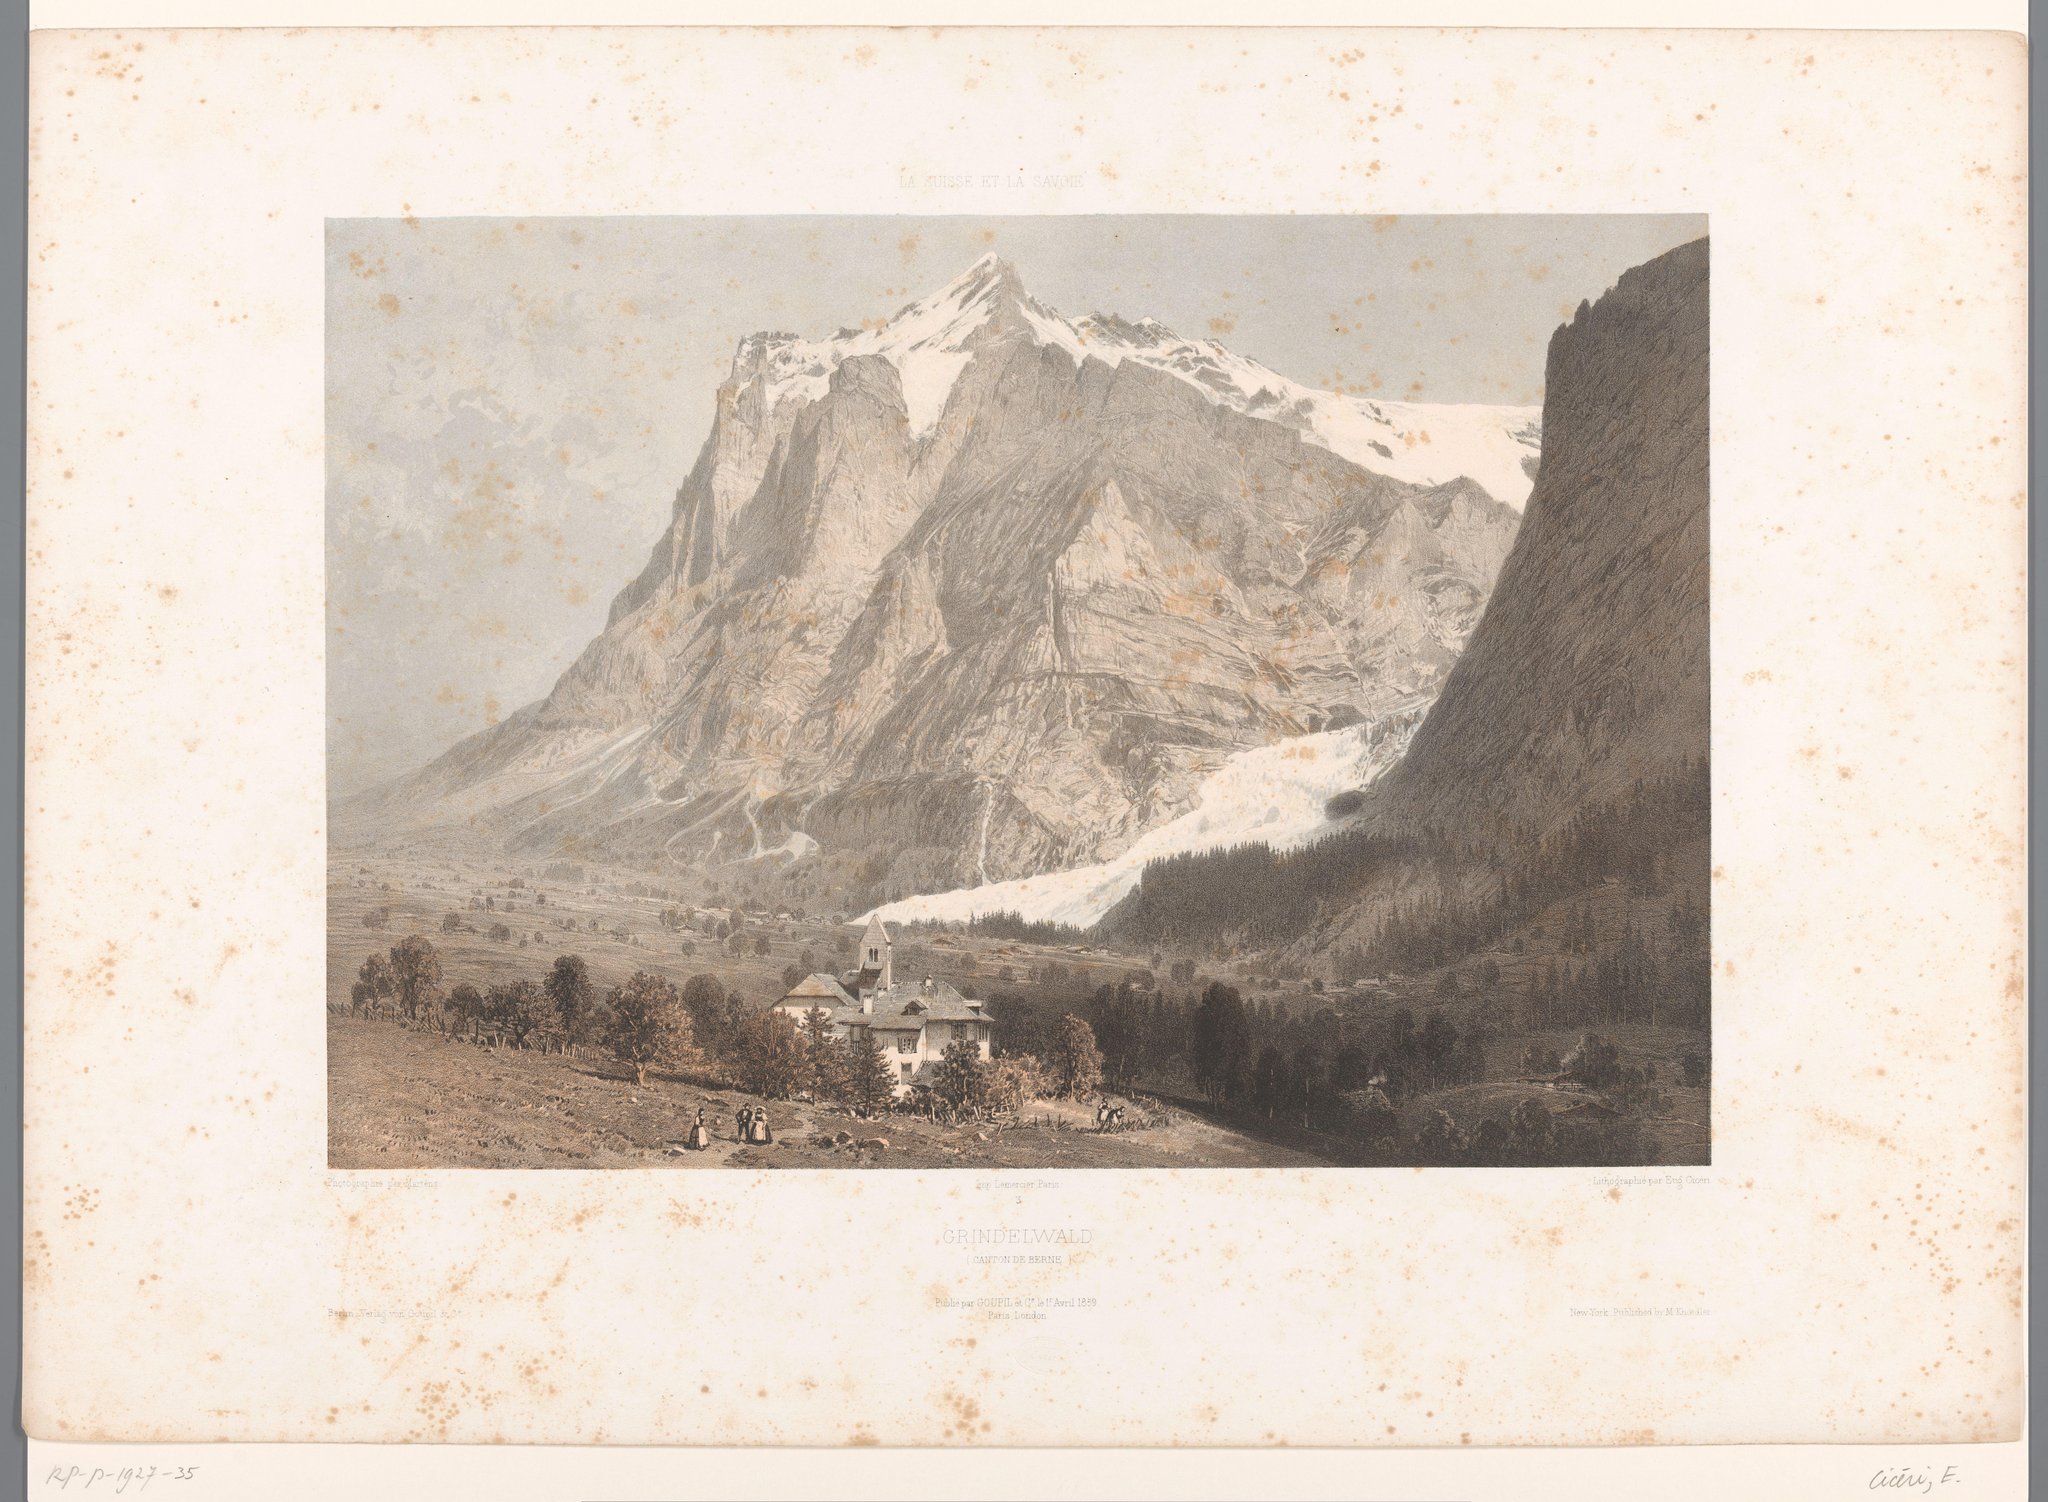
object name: print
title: Zicht op Grindelwald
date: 1859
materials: paper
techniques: lithograph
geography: paris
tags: prospect of village, silhouette of village, mountain-range, snow peaks (+ landscape with figures, staffage)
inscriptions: check stamp: Lugt 1090